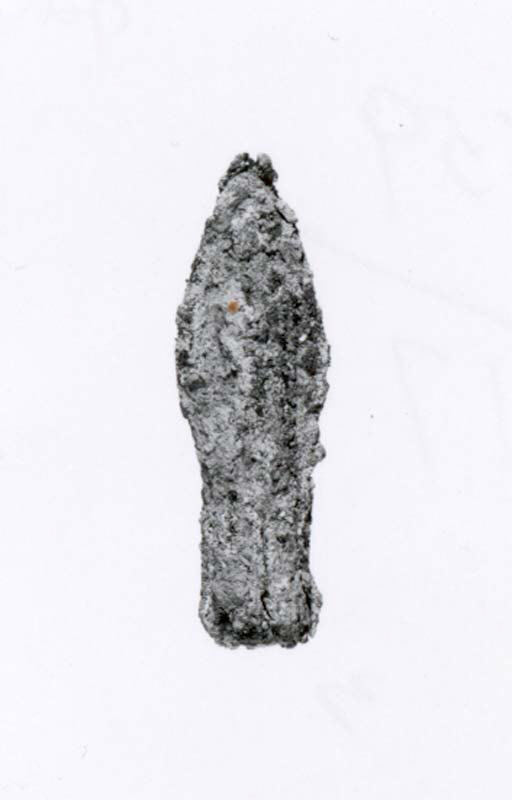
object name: arrowhead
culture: iranian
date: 700-601 BCE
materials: bronze, copper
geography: iran